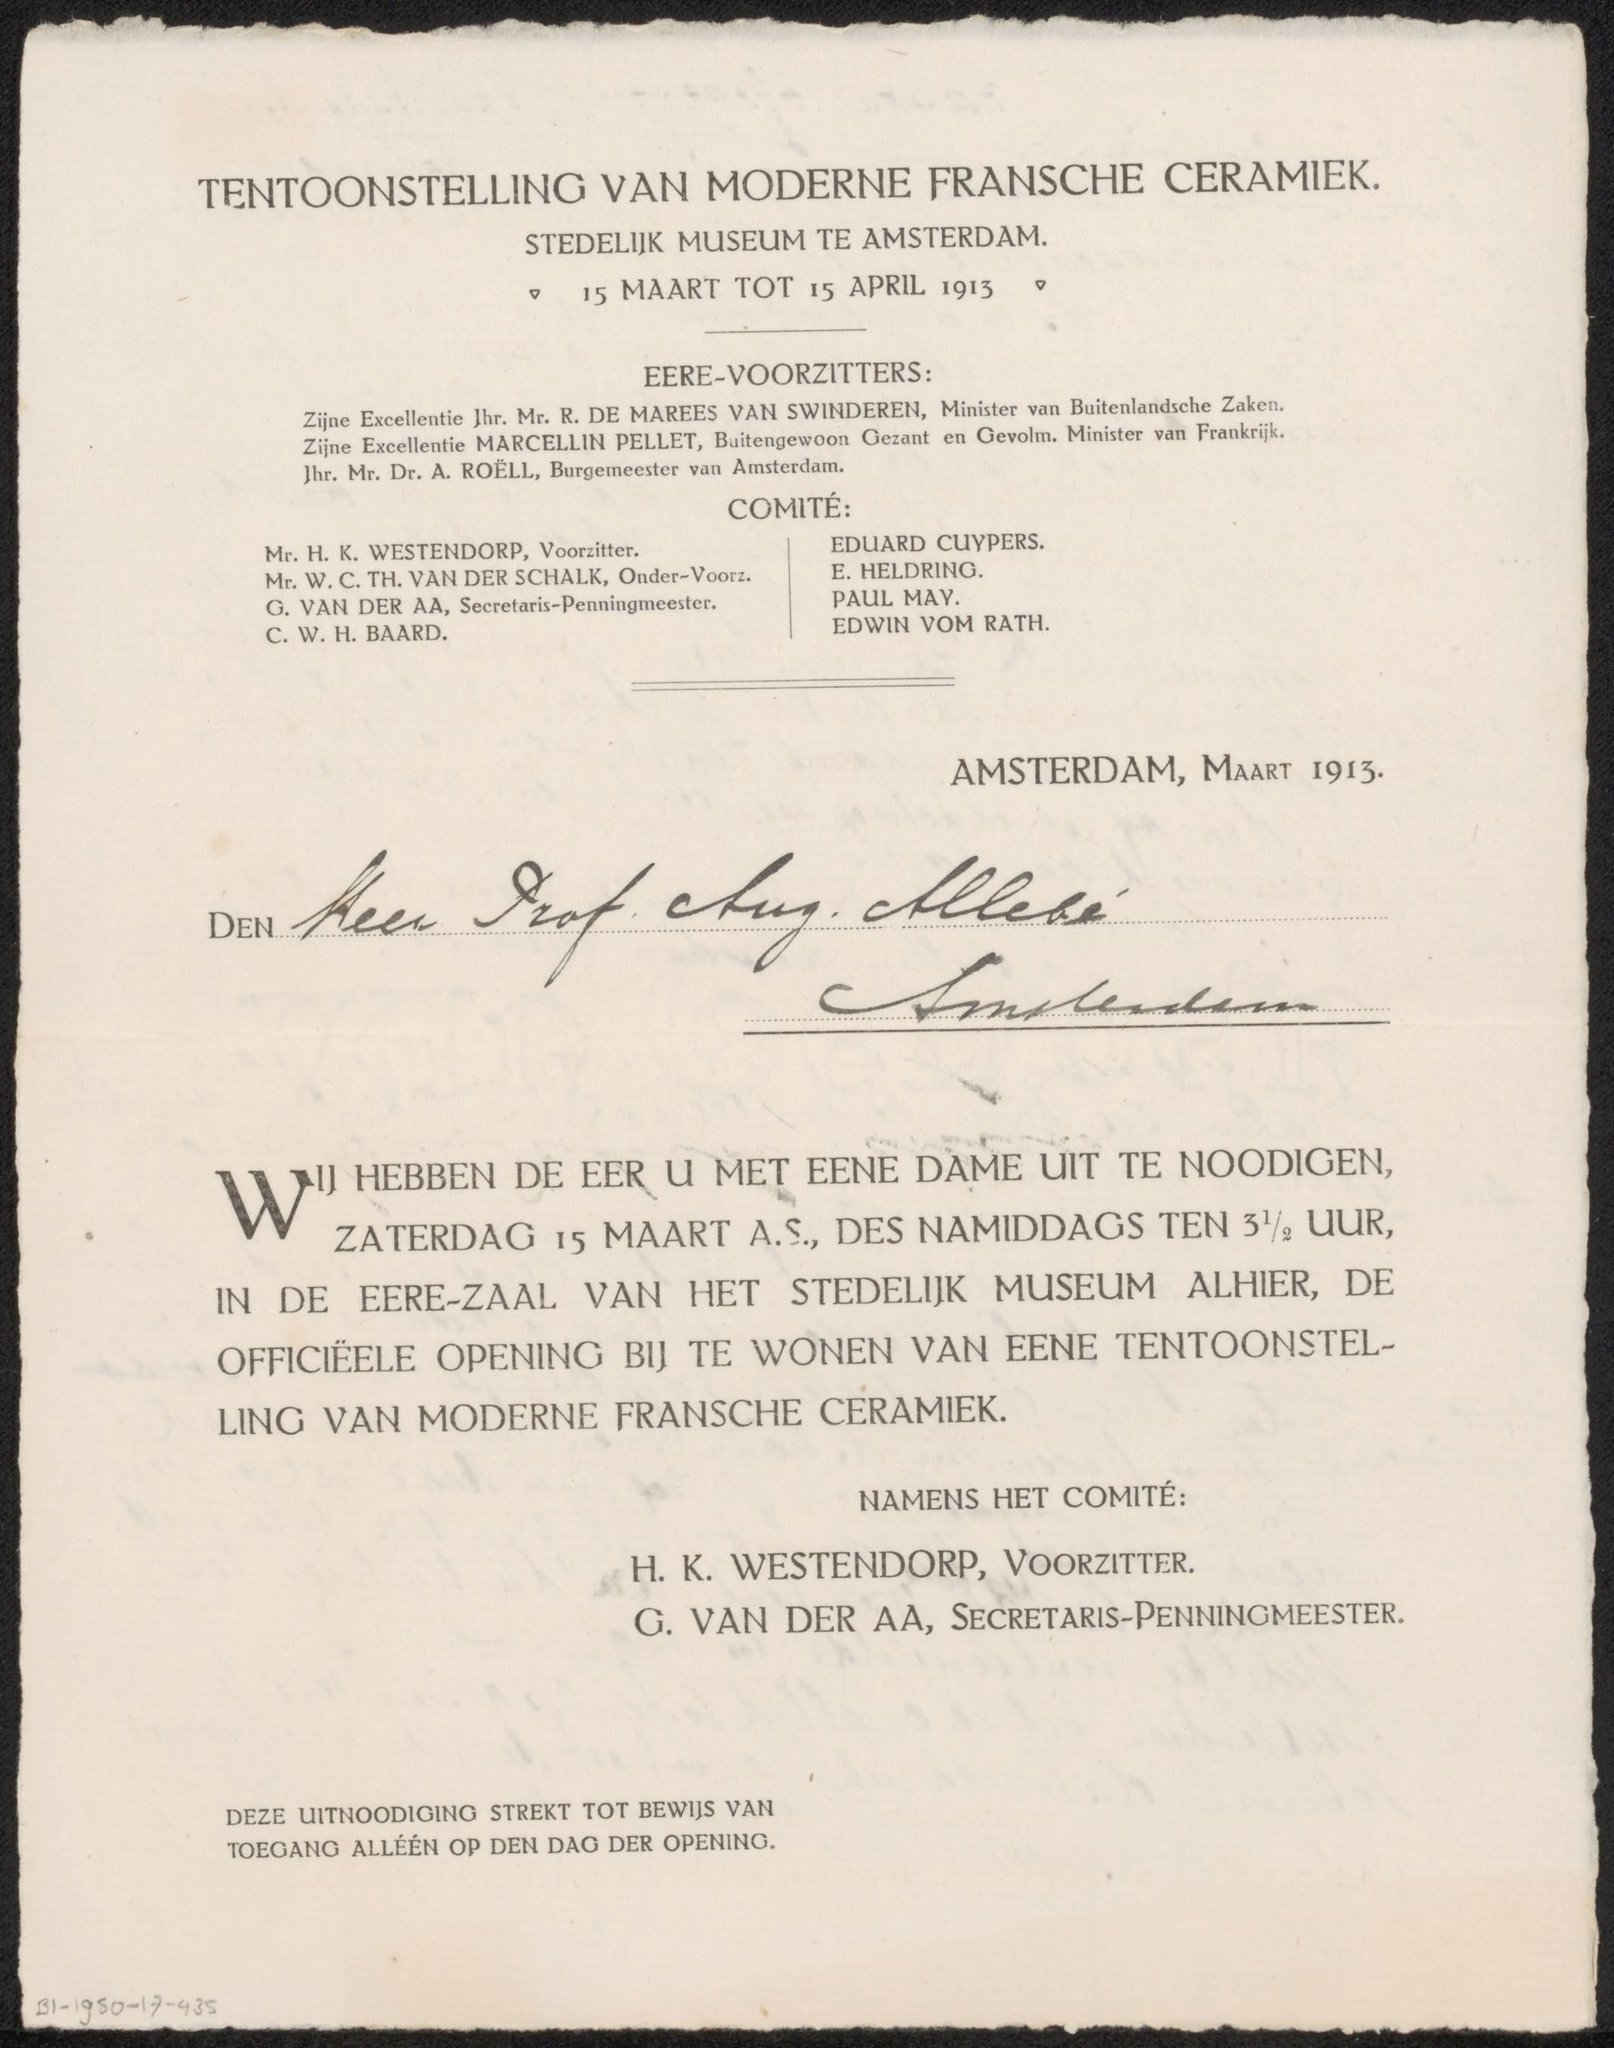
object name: letter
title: Conceptbrief aan anoniem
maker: august allebé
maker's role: draughtsman, print maker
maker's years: 1838-1927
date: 1848-1927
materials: ink, paper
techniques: pen, printing, writing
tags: amerongen, print maker, gustaaf van nifterik, painting (including book-illumination, miniature-painting)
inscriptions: watermark